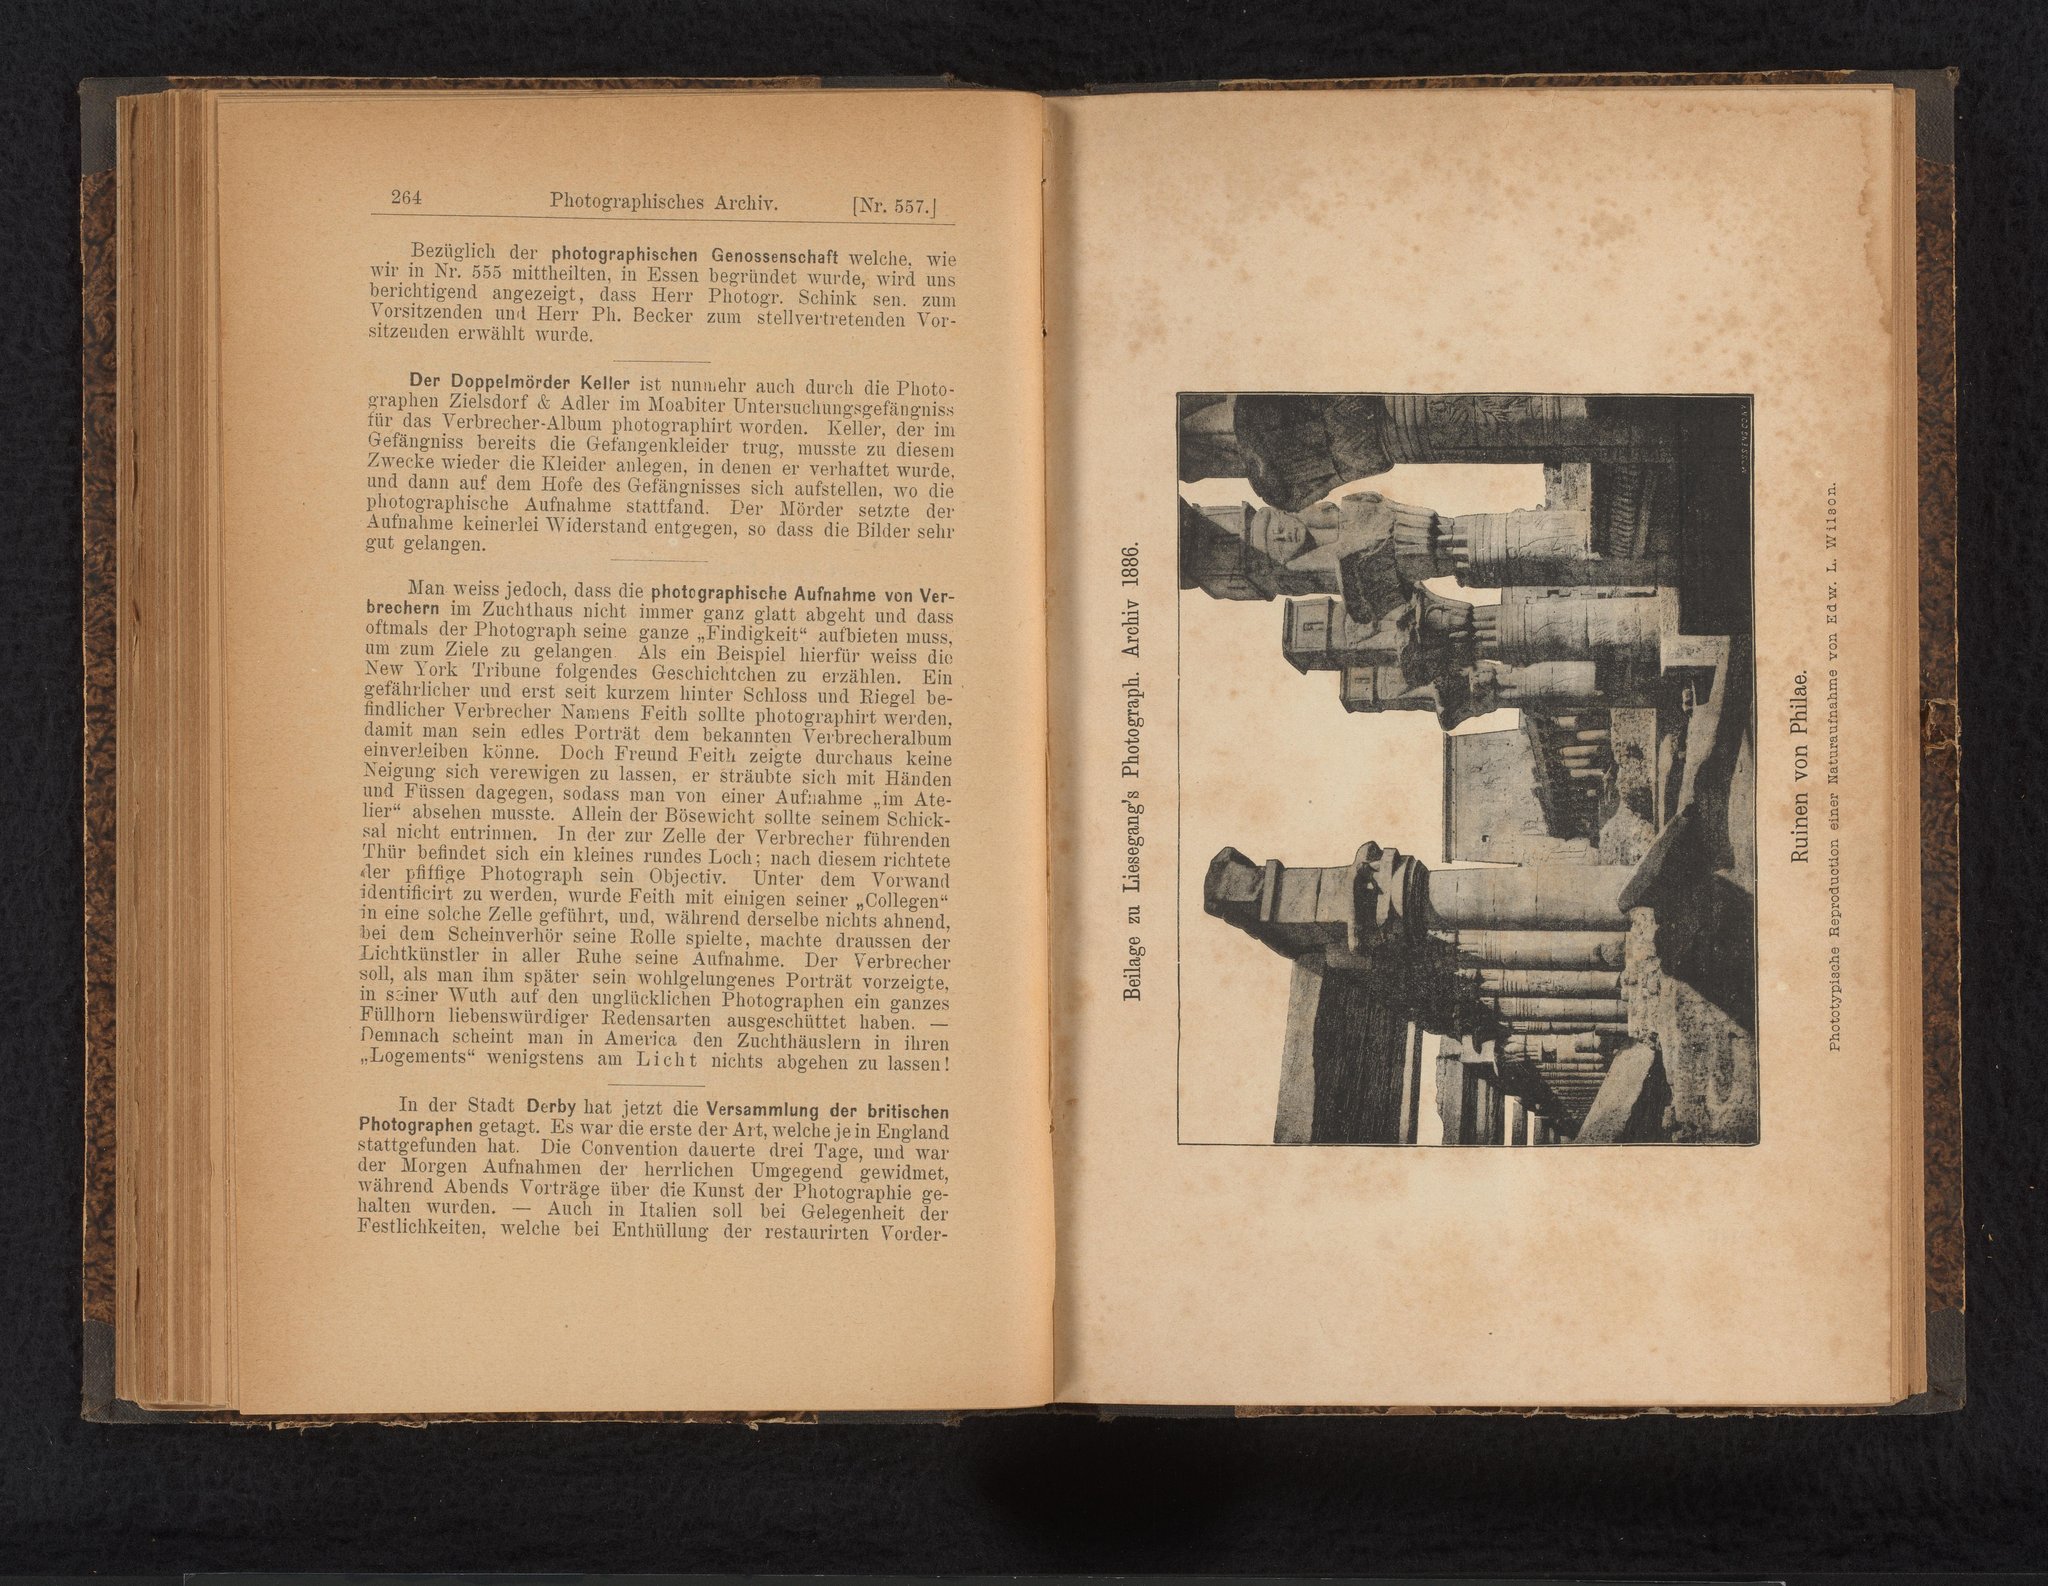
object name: photomechanical print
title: Ruïnes van het tempelcomplex te Philae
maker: edward livingston wilson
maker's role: publisher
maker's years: 1838-1903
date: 1881-1886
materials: paper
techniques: autotype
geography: philae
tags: temple, shrine ~ egyptian religion, ruin of a building ~ architecture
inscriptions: signature: ‘Moss Eng. Co. N.Y.’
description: Prent op ongenummerde pagina tegenover pagina 264.